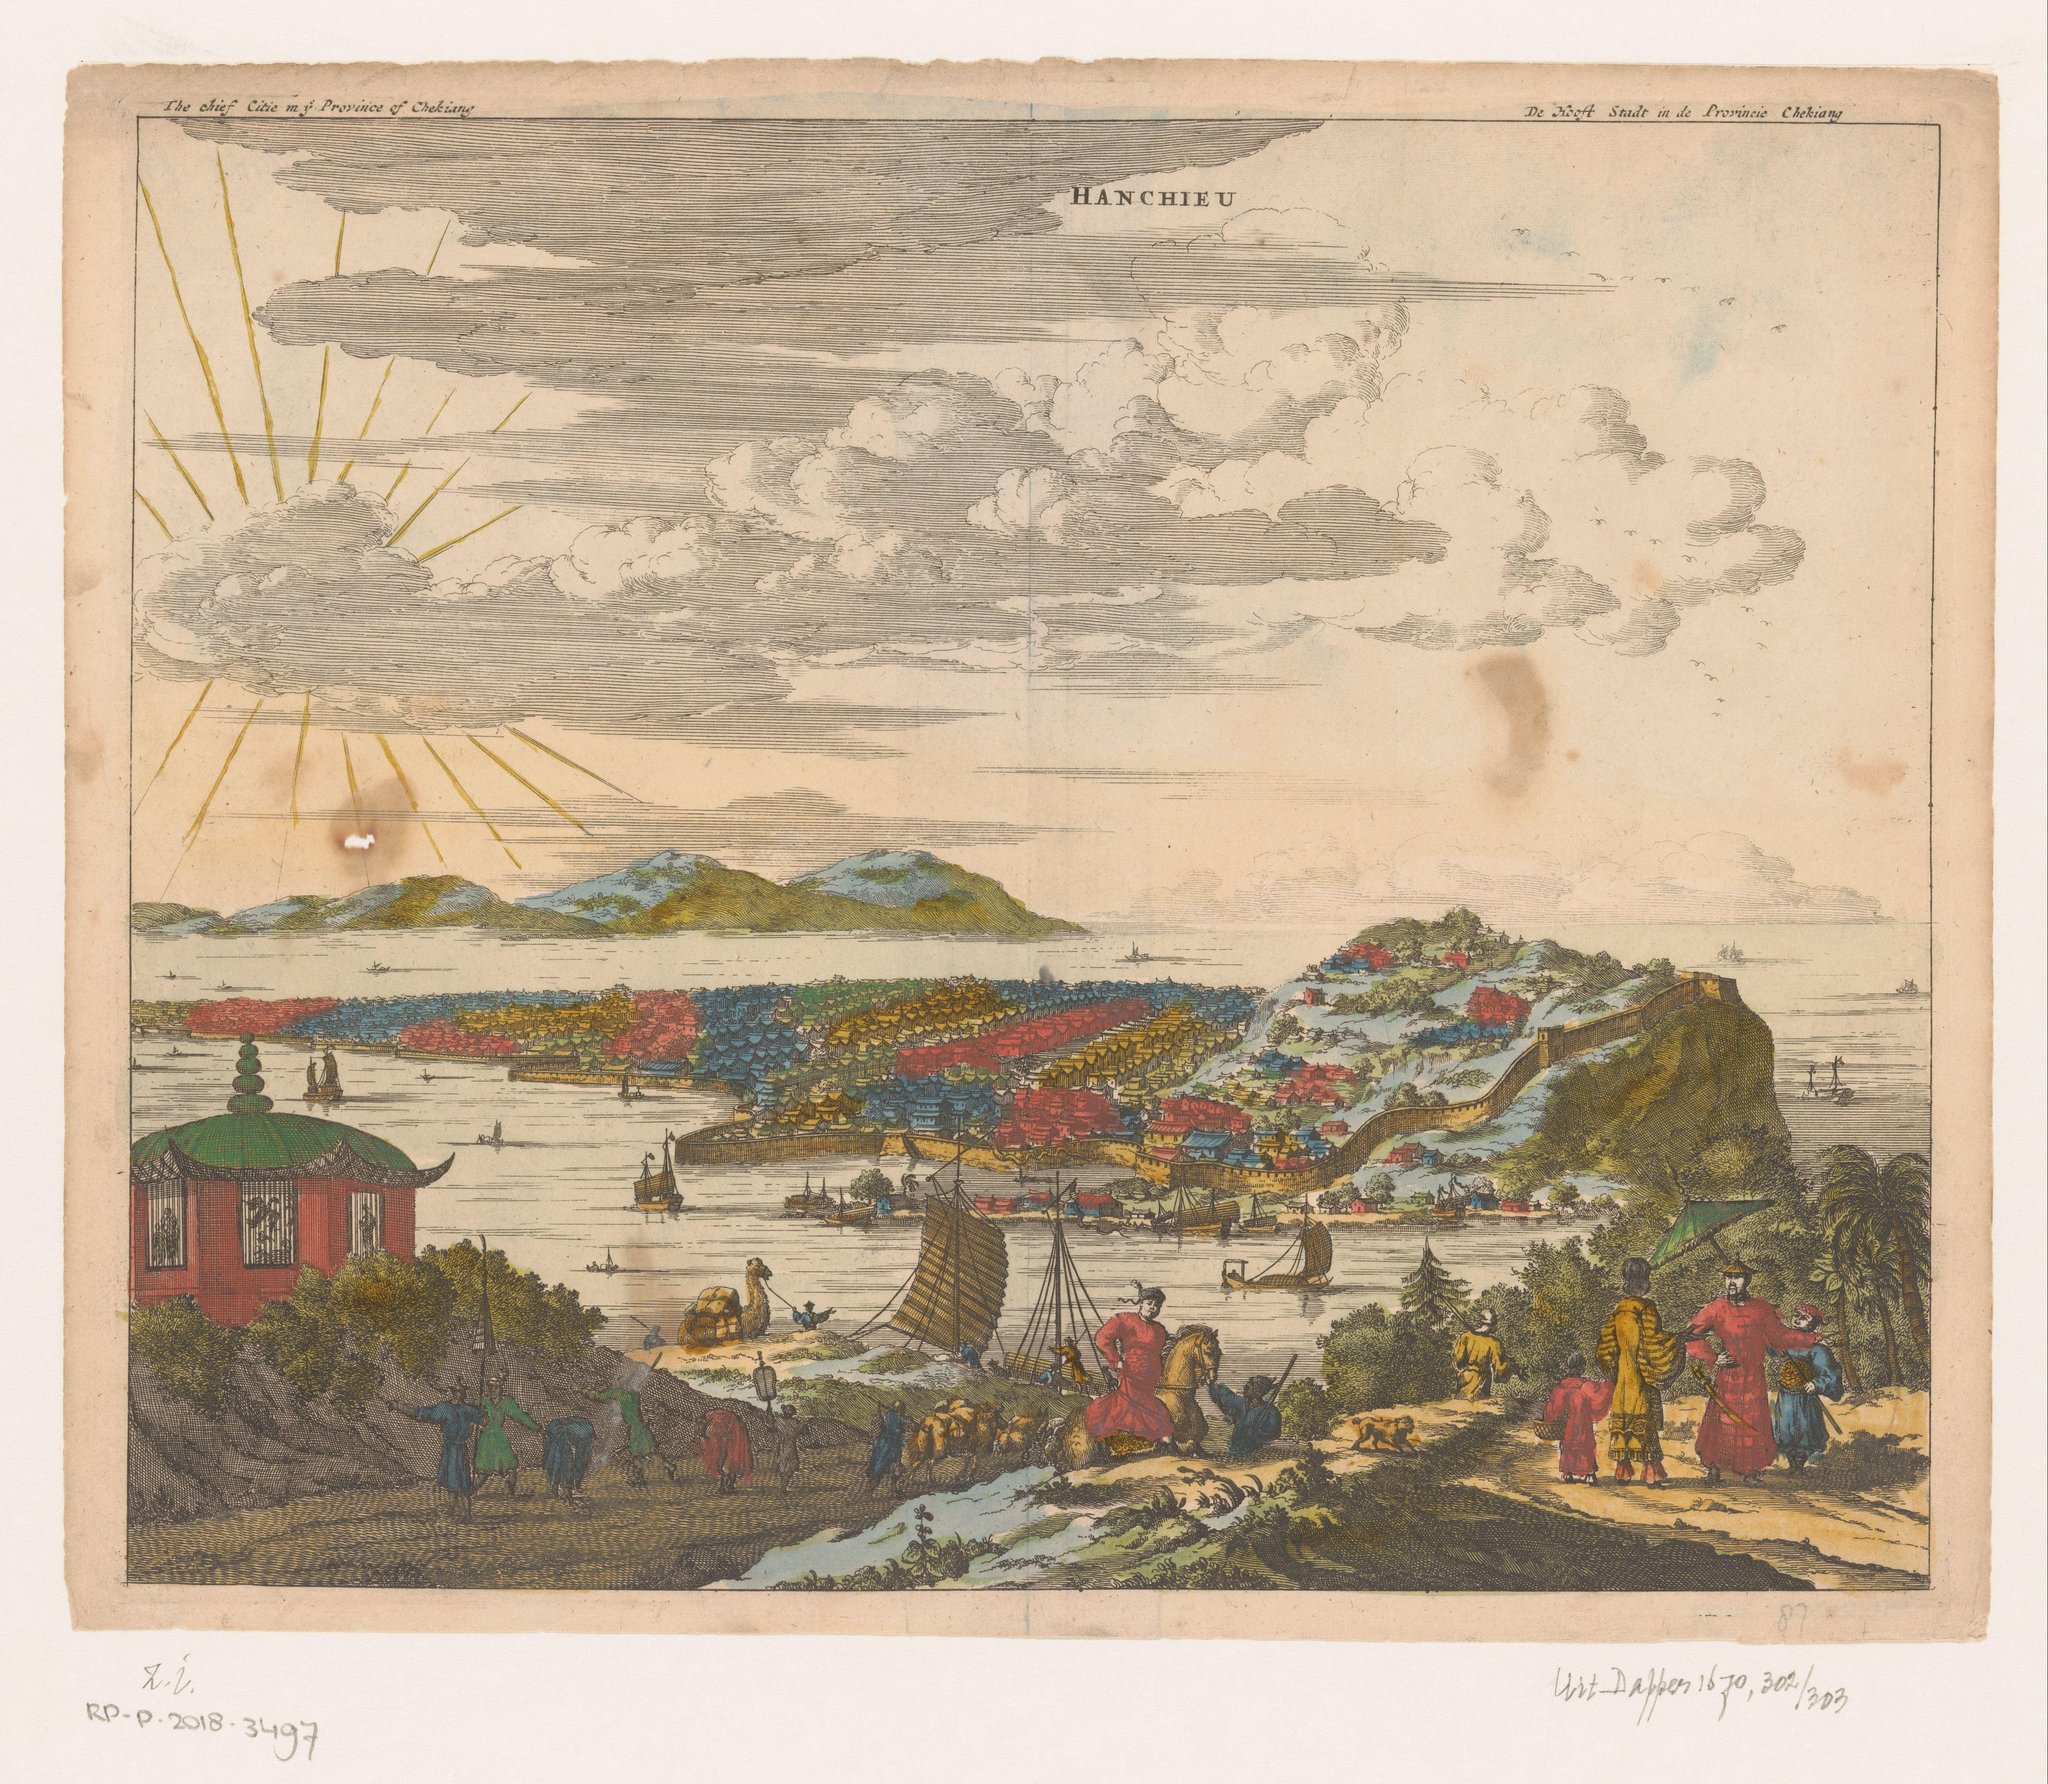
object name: print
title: Hanchieu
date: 1671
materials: paper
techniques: engraving, hand coloring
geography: london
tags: river, prospect of city, town panorama, silhouette of city, china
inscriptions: collector's mark: Lugt 2228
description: Ommuurde Chinese stad op een eiland, vanaf de tegenoverliggende rivieroever gezien. Figuren op de voorgrond en Chinese zeilschepen op de rivier. Linksvoor een klein bouwwerk. Boven de prent een opschrift in Engels (links): "The chief Citie in y[e] Province of Chekiang", en in het Nederlands (rechts): "De Hooft Stadt in de Provincie Chekiang".